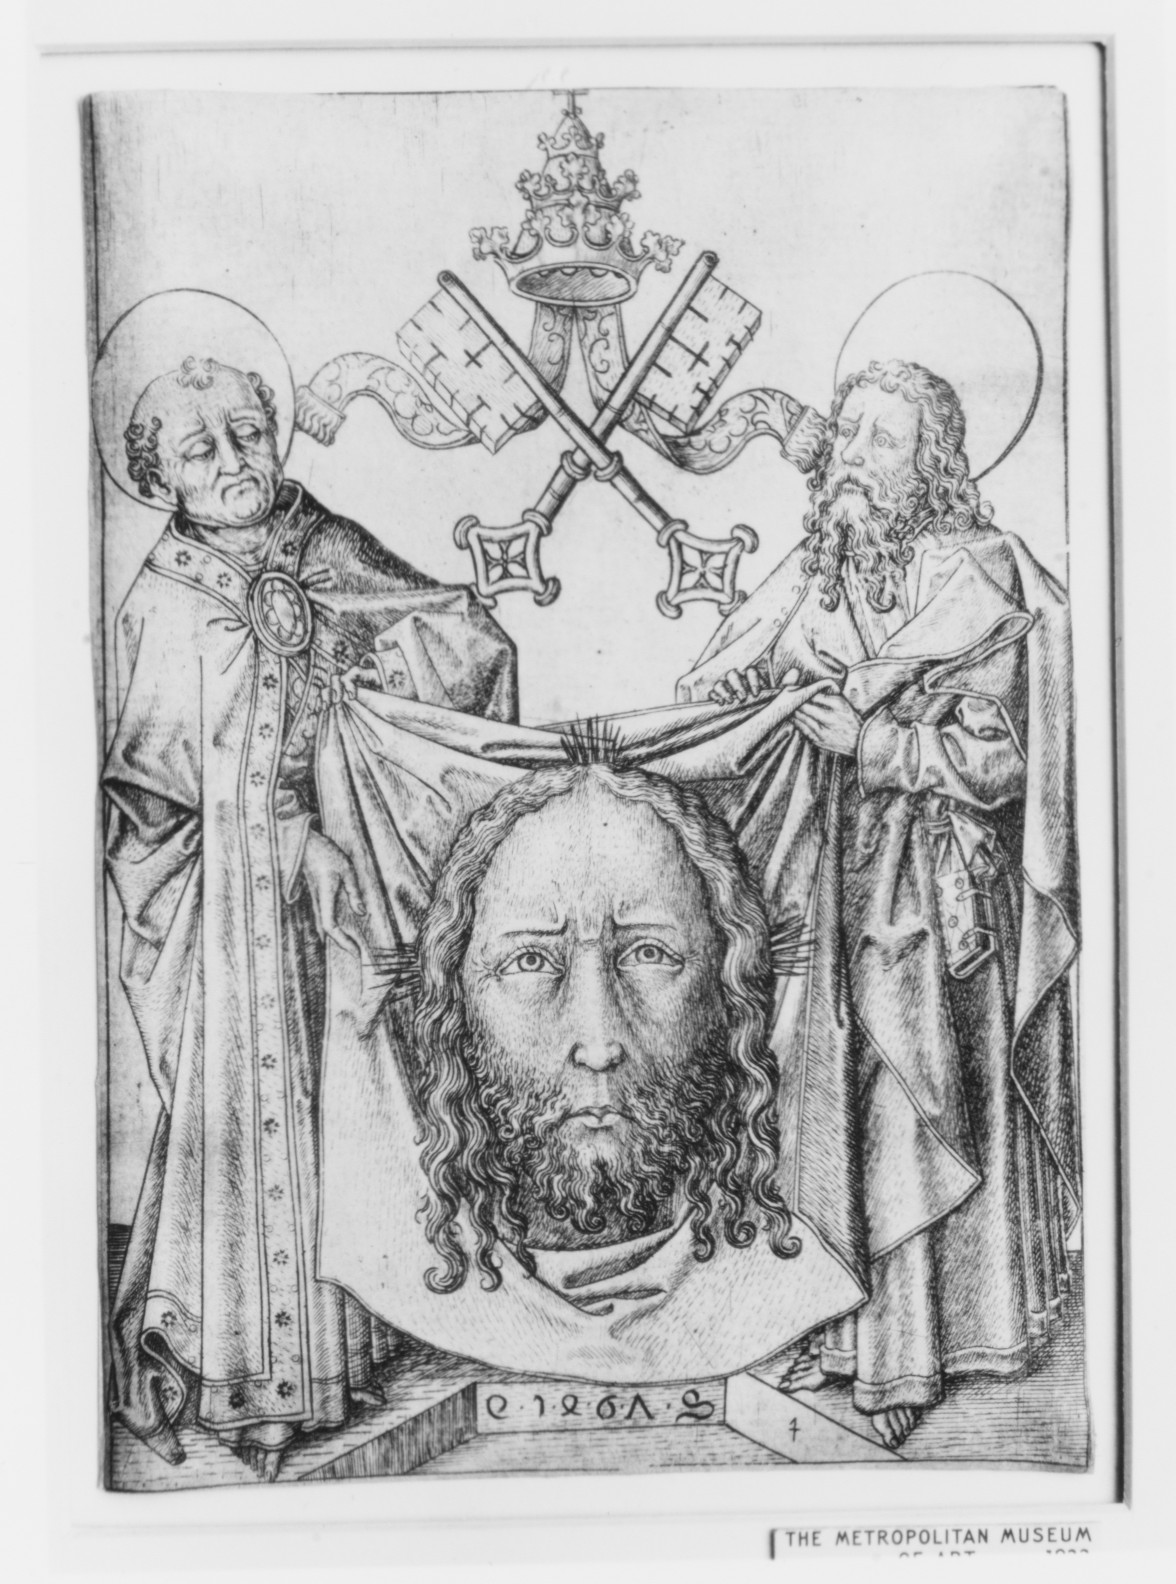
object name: print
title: The Sudarium with St. Peter and St. Paul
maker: master es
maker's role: artist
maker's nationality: german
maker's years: 1445-1467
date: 1401-1500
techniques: engraving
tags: faces,saint paul,saint peter